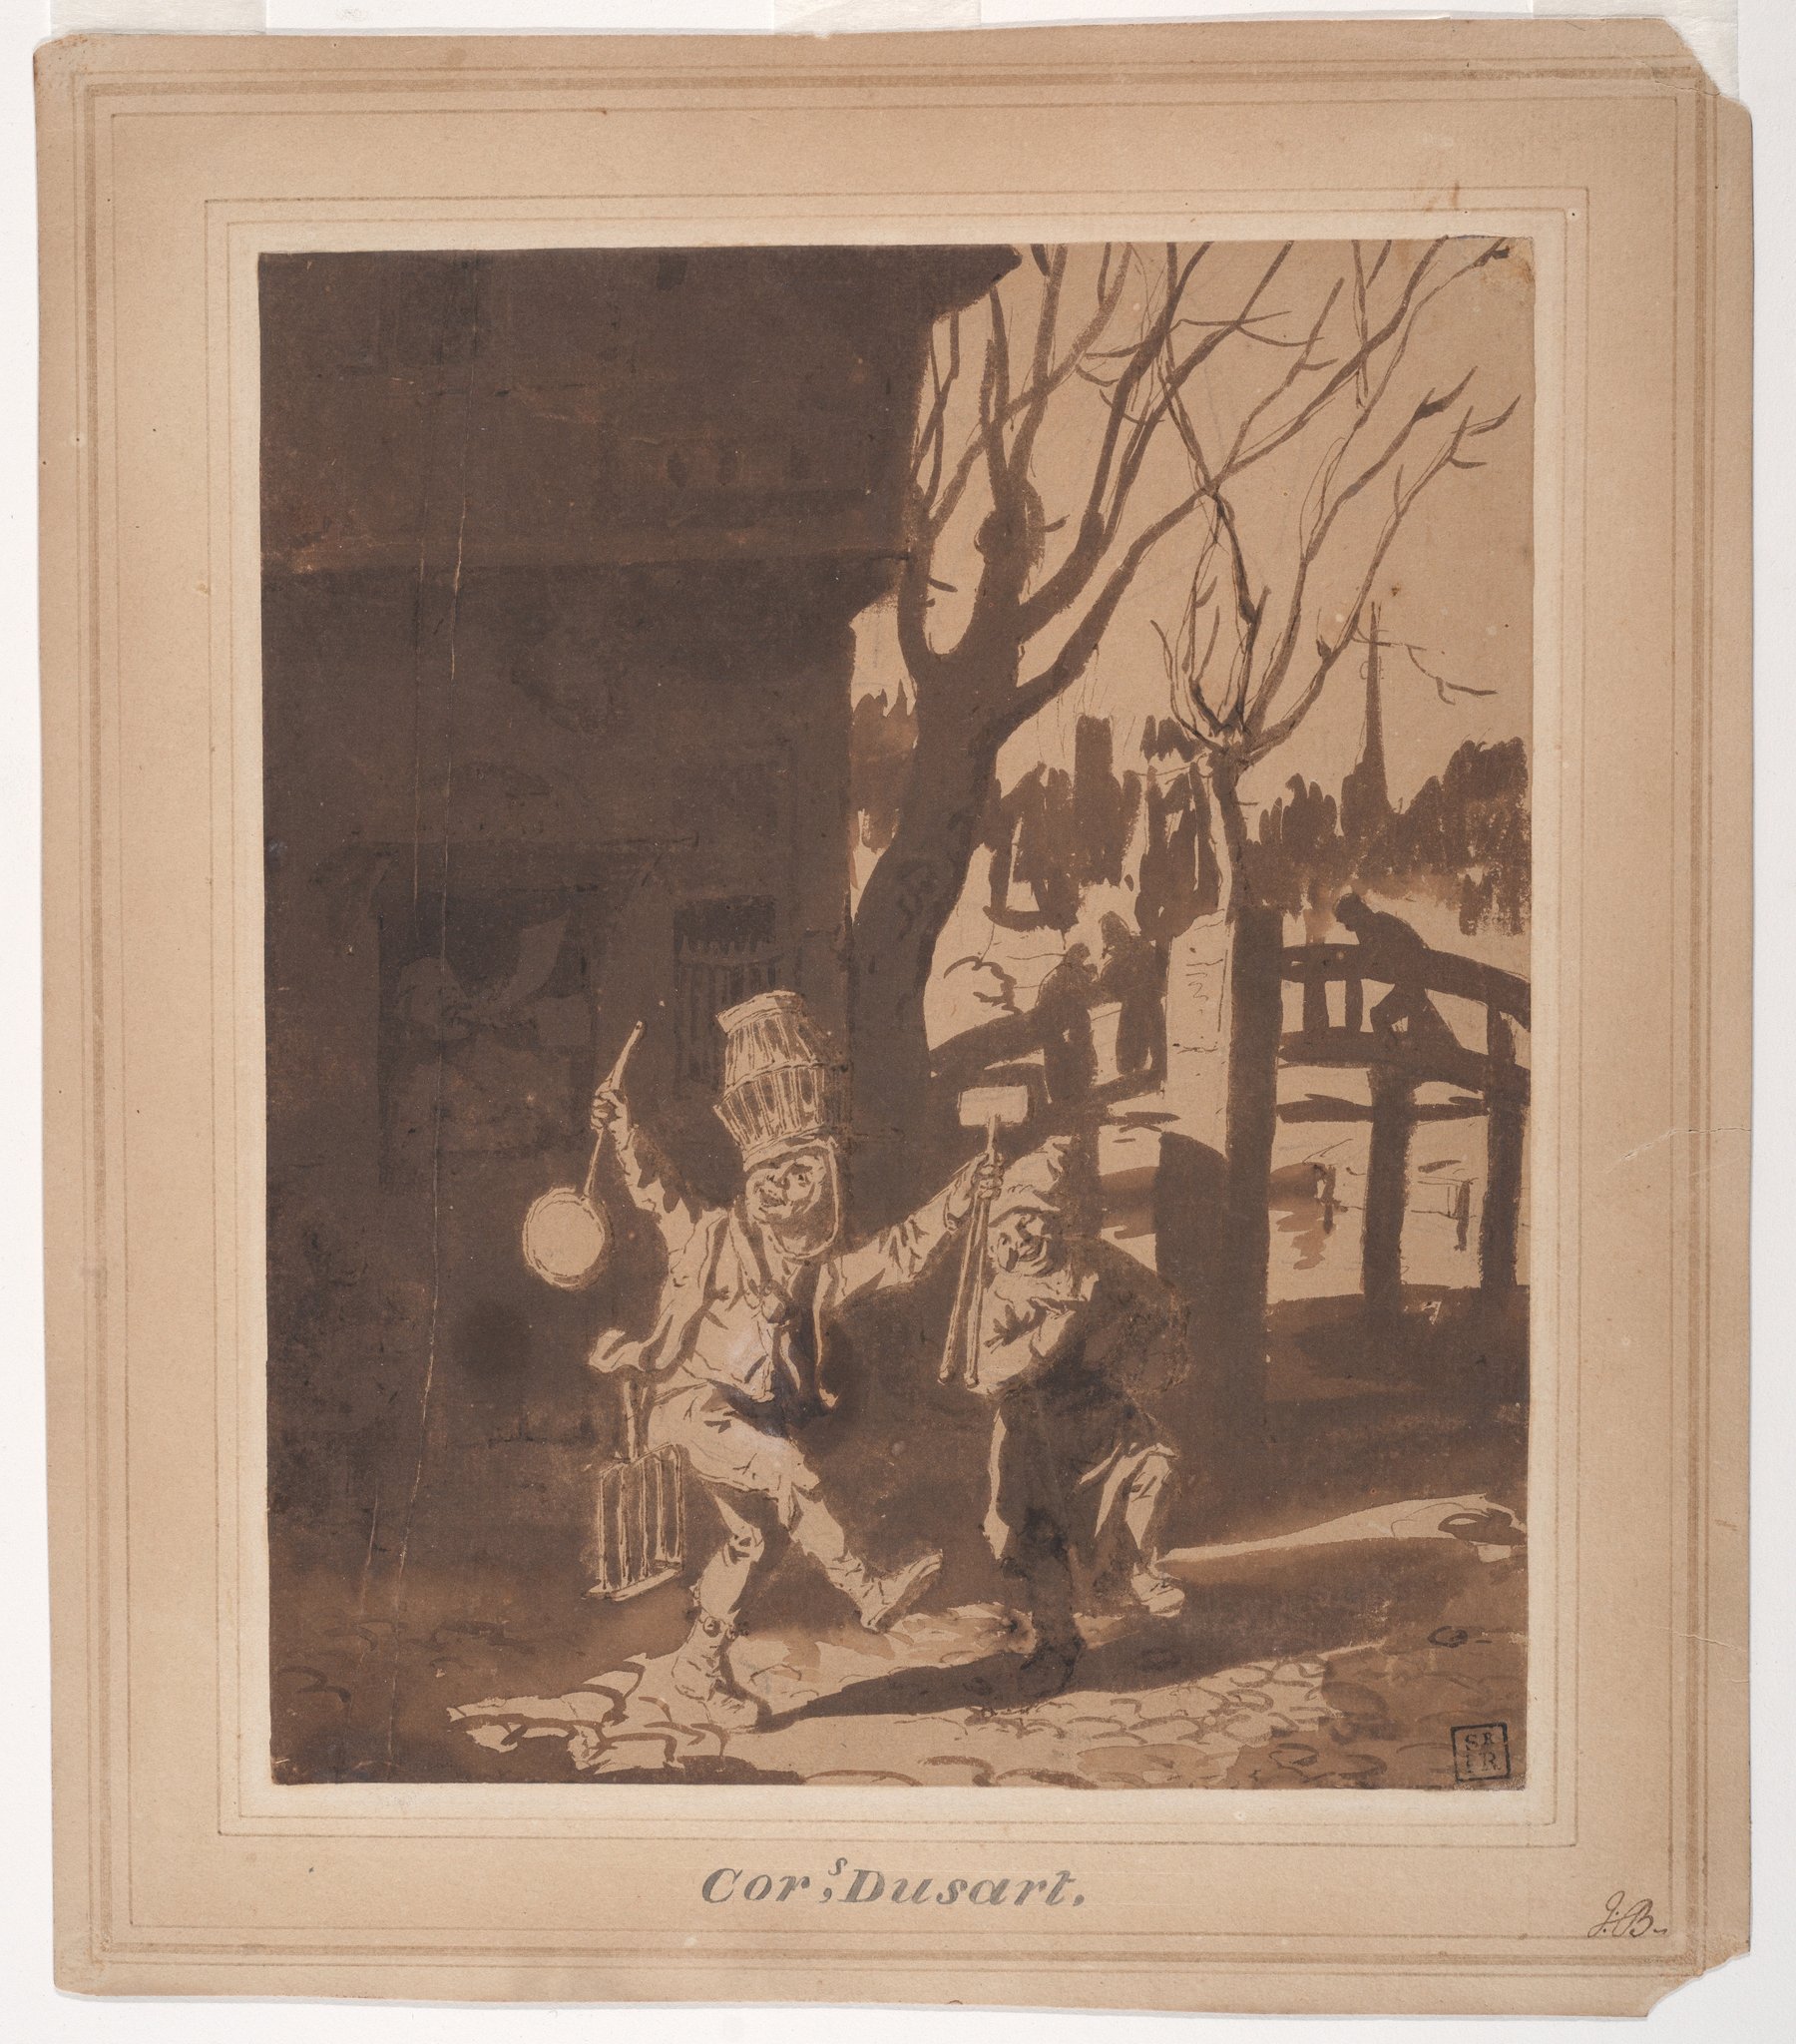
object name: drawing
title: The Baker's Children Playing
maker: cornelis dusart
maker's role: artist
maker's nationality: dutch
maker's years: 1660-1704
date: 1604-1680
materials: chalk, ink, paper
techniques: brush, pen, wash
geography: netherlands